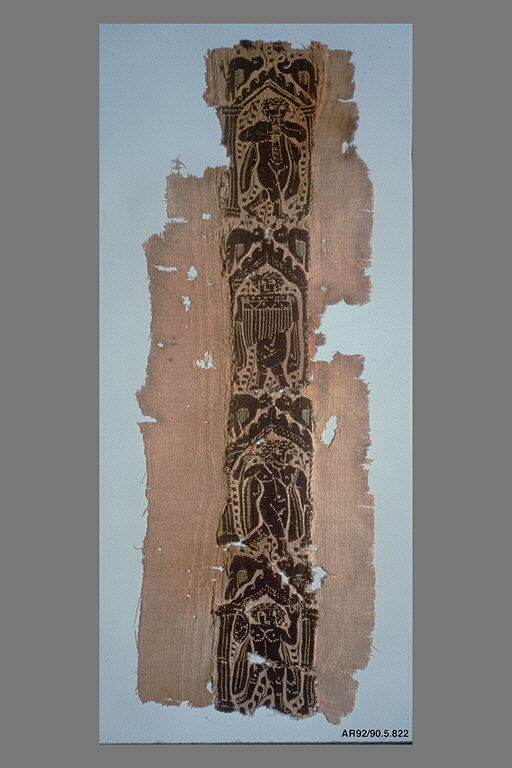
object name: band fragment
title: Fragment of a Band with Musicians and Warriors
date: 301-600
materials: linen, wool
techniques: weave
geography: egypt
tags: men,flutes,musicians